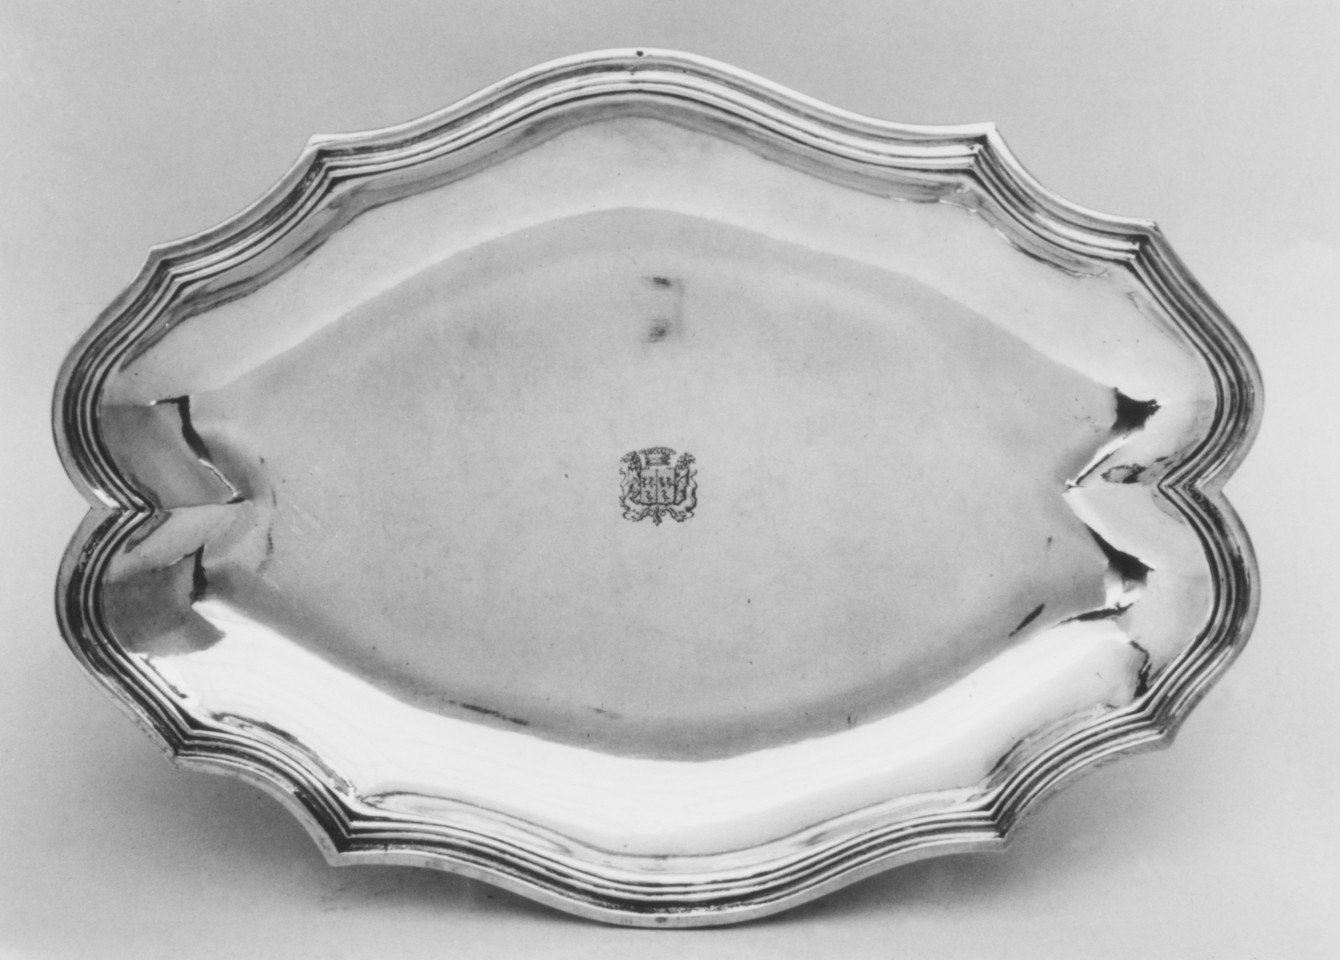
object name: platter or tray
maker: widow of jean-pierre-elou-louis piette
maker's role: maker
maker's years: 1776-1790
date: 1783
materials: silver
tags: coat of arms